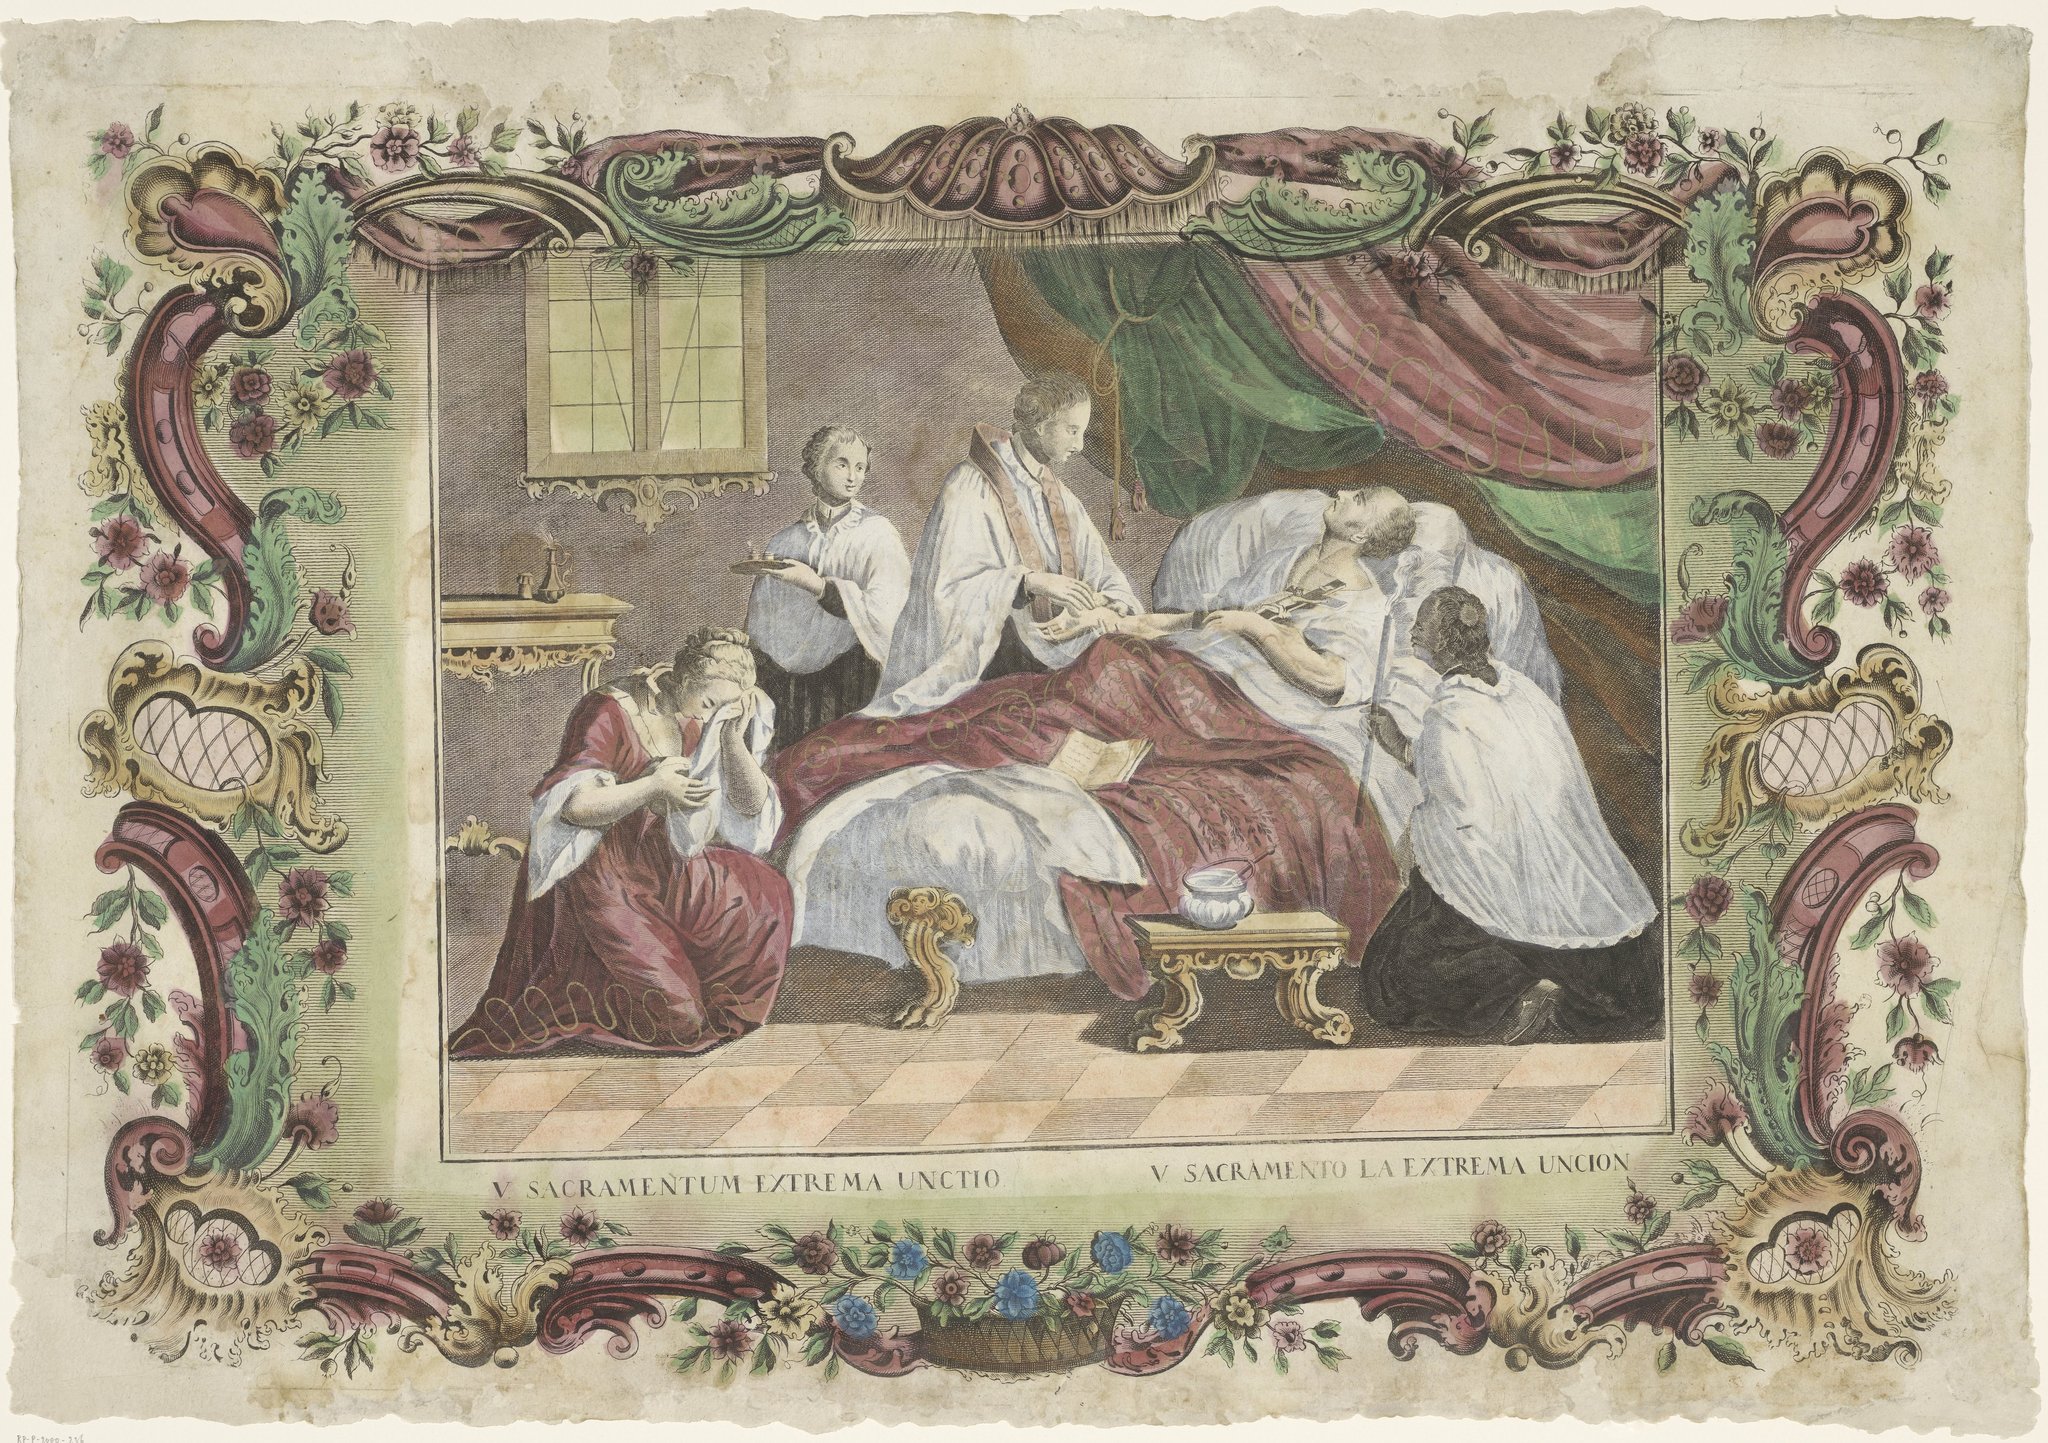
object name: print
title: V. sacramentum extrema unctio / V. sacramento la extrema uncion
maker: giovanni volpato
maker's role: ceramicist, print maker, printer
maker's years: 1735-1803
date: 1700-1799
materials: paper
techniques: colour, engraving, etching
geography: italy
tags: extreme unction ~ the last of the seven sacraments, ornaments ~ art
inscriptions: collector's mark: Lugt 2760, collector's mark: Lugt 2228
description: Het sacrament van het laatste oliesel. Een stervende ligt in een bed onder een baldakijn. Een priester dient hem het laatste oliesel toe. Links en rechts van het bed een knielende misdienaar. Aan het voeteneinde een huilende dame. Titel in twee talen onder voorstelling. De scène is gevat in een ornamentrand.